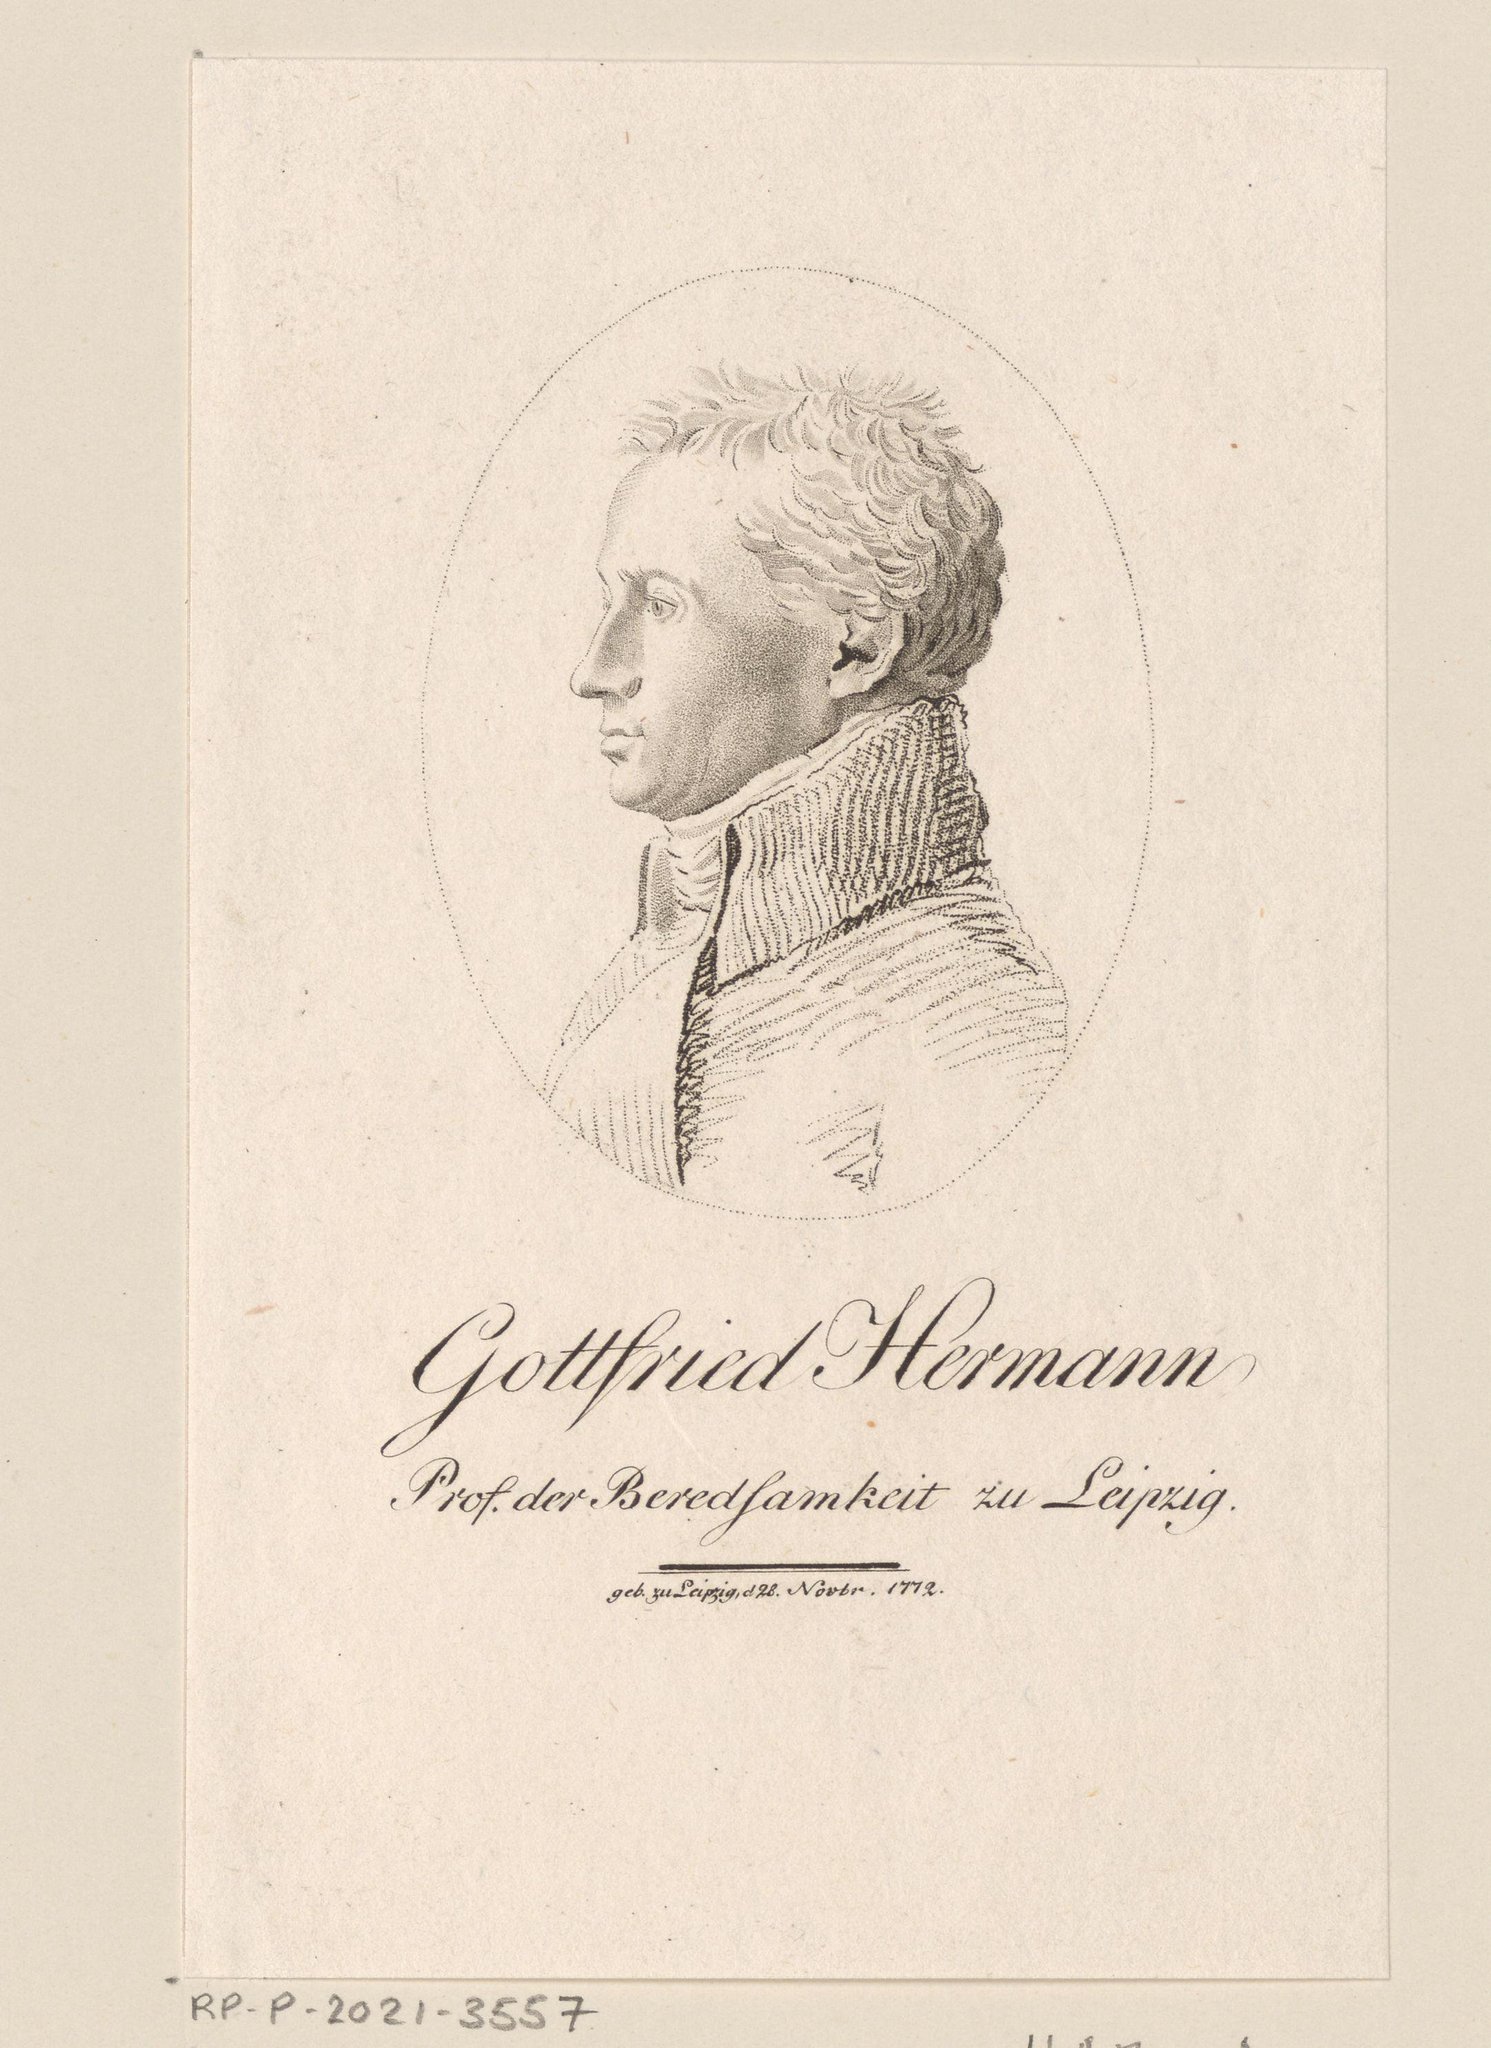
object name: print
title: Portret van Johann Gottfried Jakob Hermann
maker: Anonymous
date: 1800-1849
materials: paper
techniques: engraving, roulette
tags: scholar, philosopher, historical persons